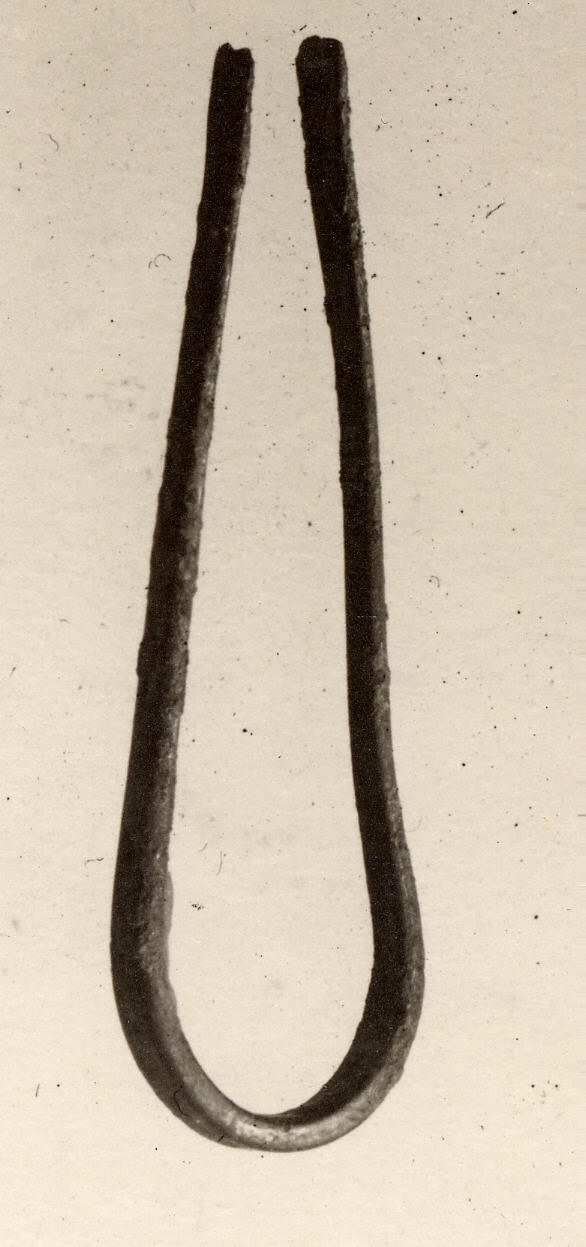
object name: tweezer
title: Tweezers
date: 1640-1550 BCE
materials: bronze, copper alloy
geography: egypt